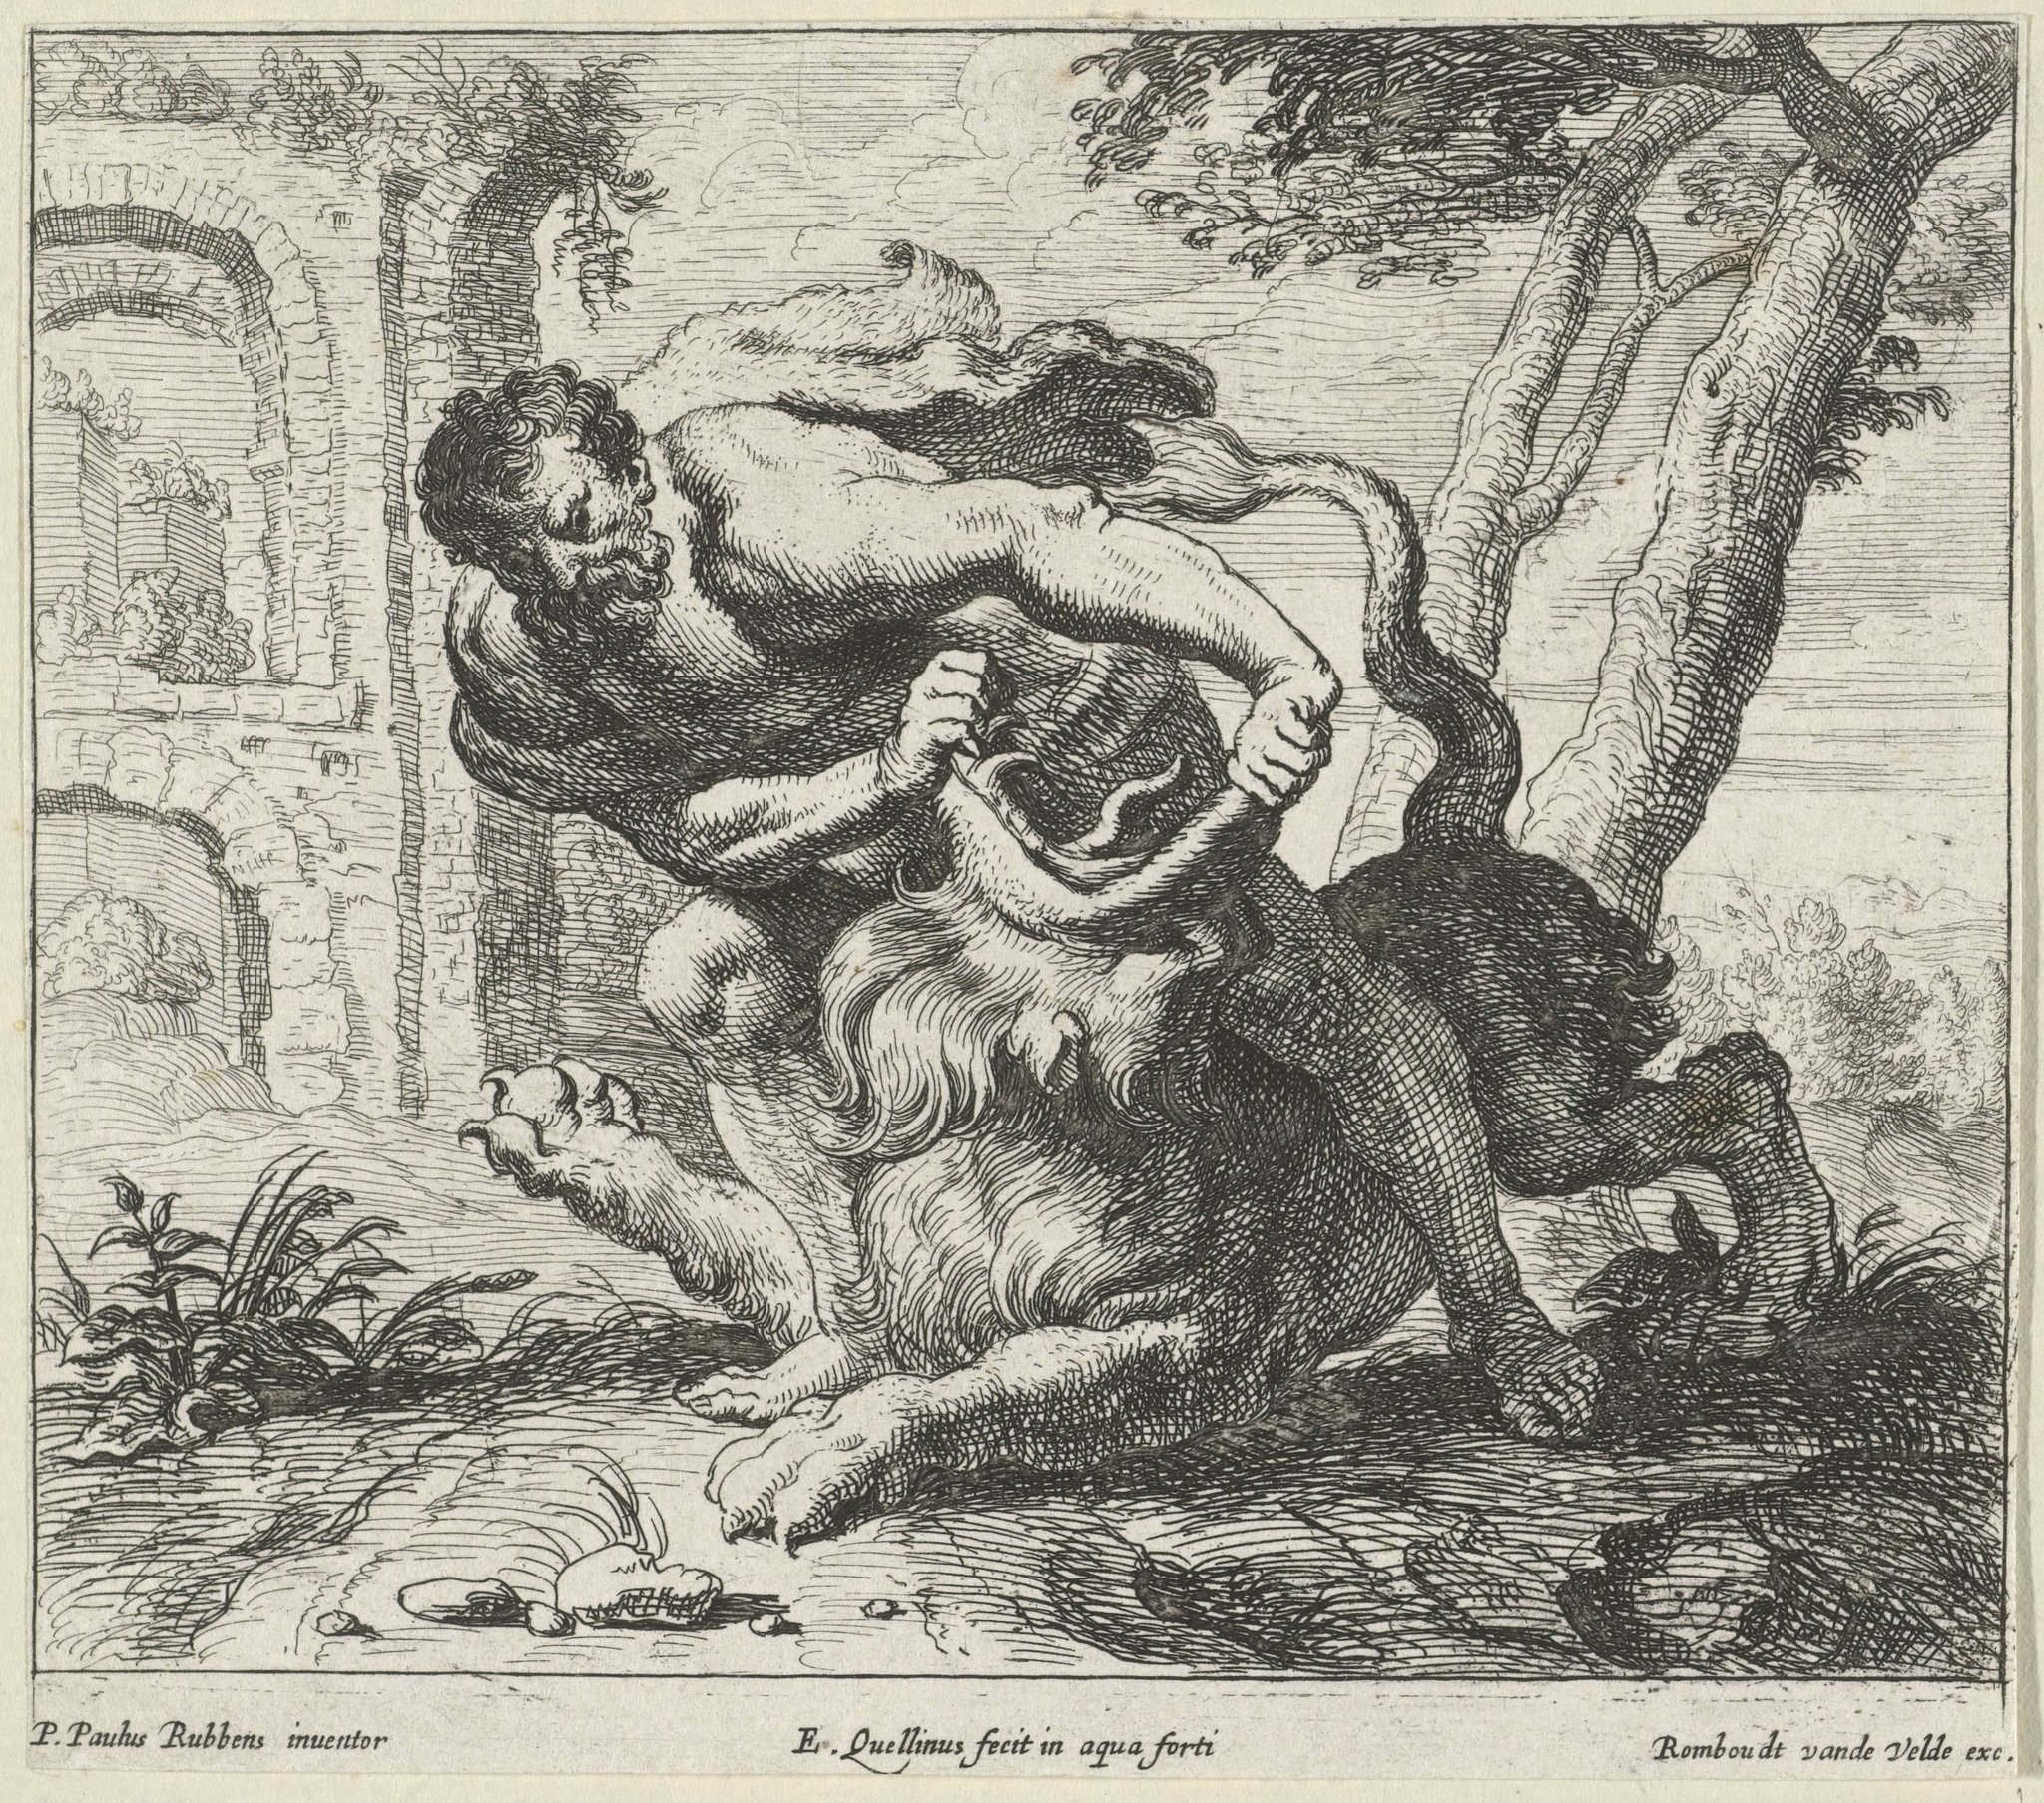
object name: print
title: Simson en de leeuw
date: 1617-1678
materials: paper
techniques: engraving, etching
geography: antwerp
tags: samson kills the lion with his bare hands, landscape with ruins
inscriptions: collector's mark: Lugt 240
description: Voor een ruïne vecht Simson met een leeuw, die hij uiteindelijk met zijn blote handen zal doden.